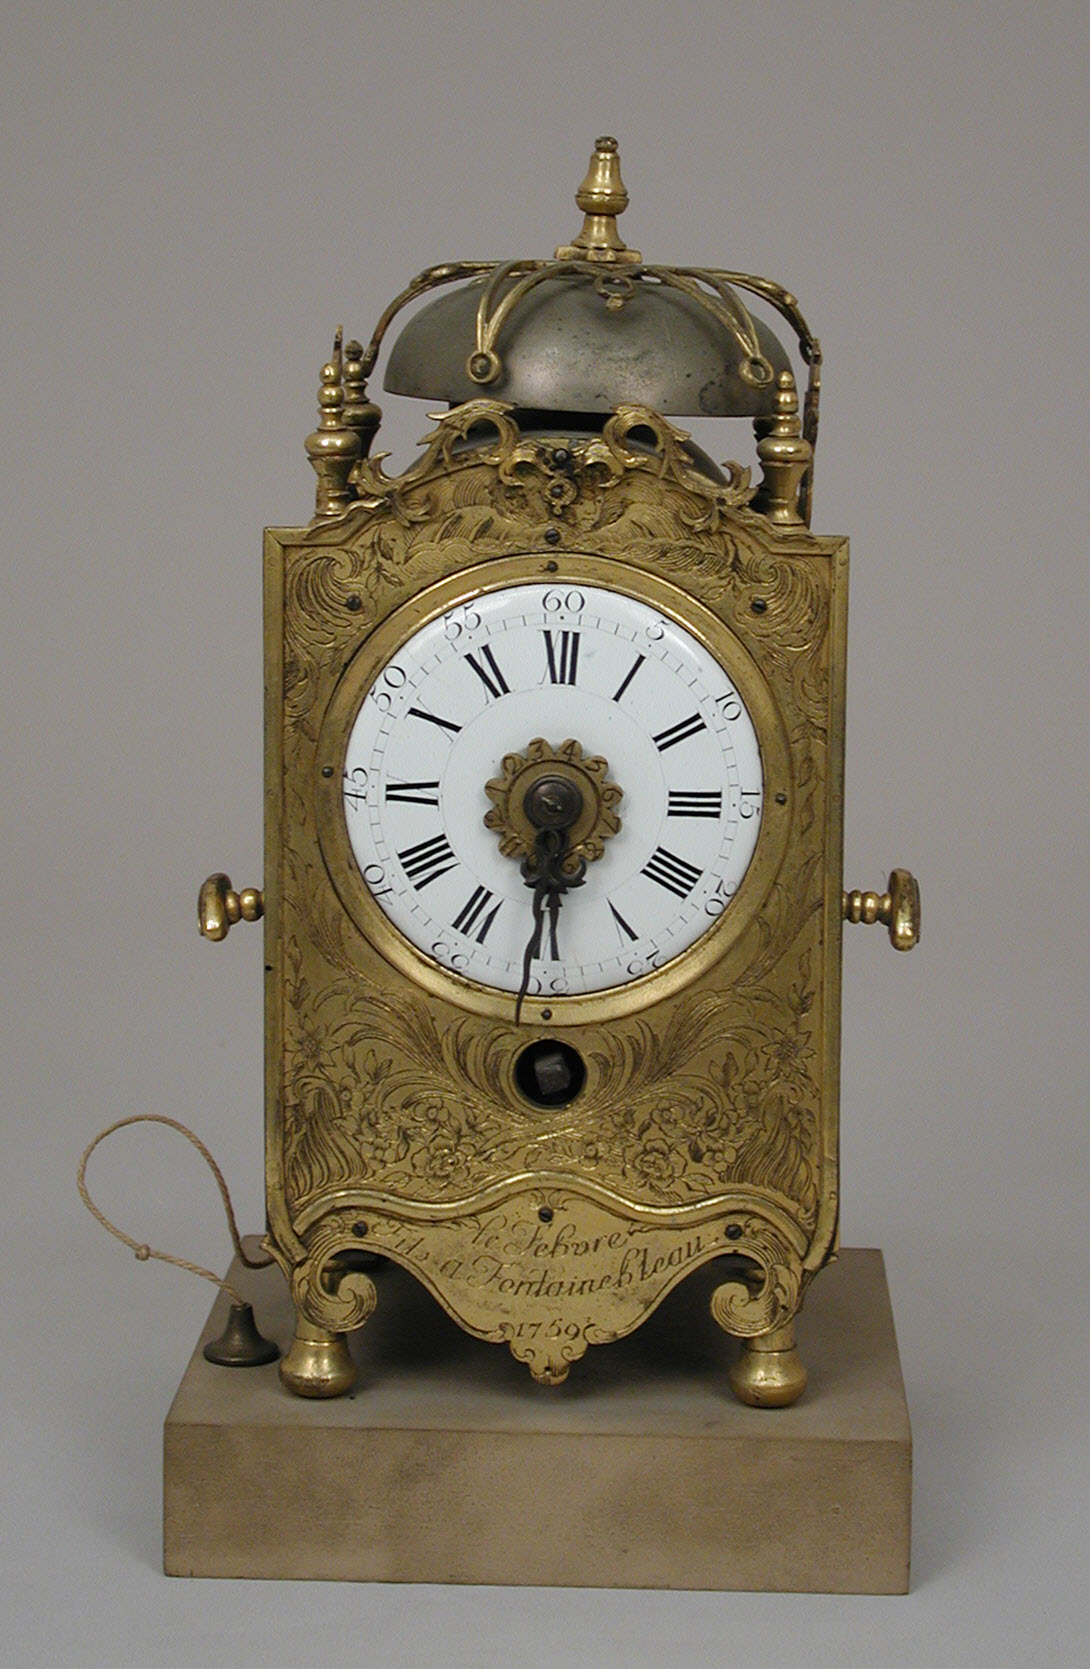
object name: clock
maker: le febvre, fils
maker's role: maker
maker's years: 1709-1809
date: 1701-1800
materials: brass, gilt